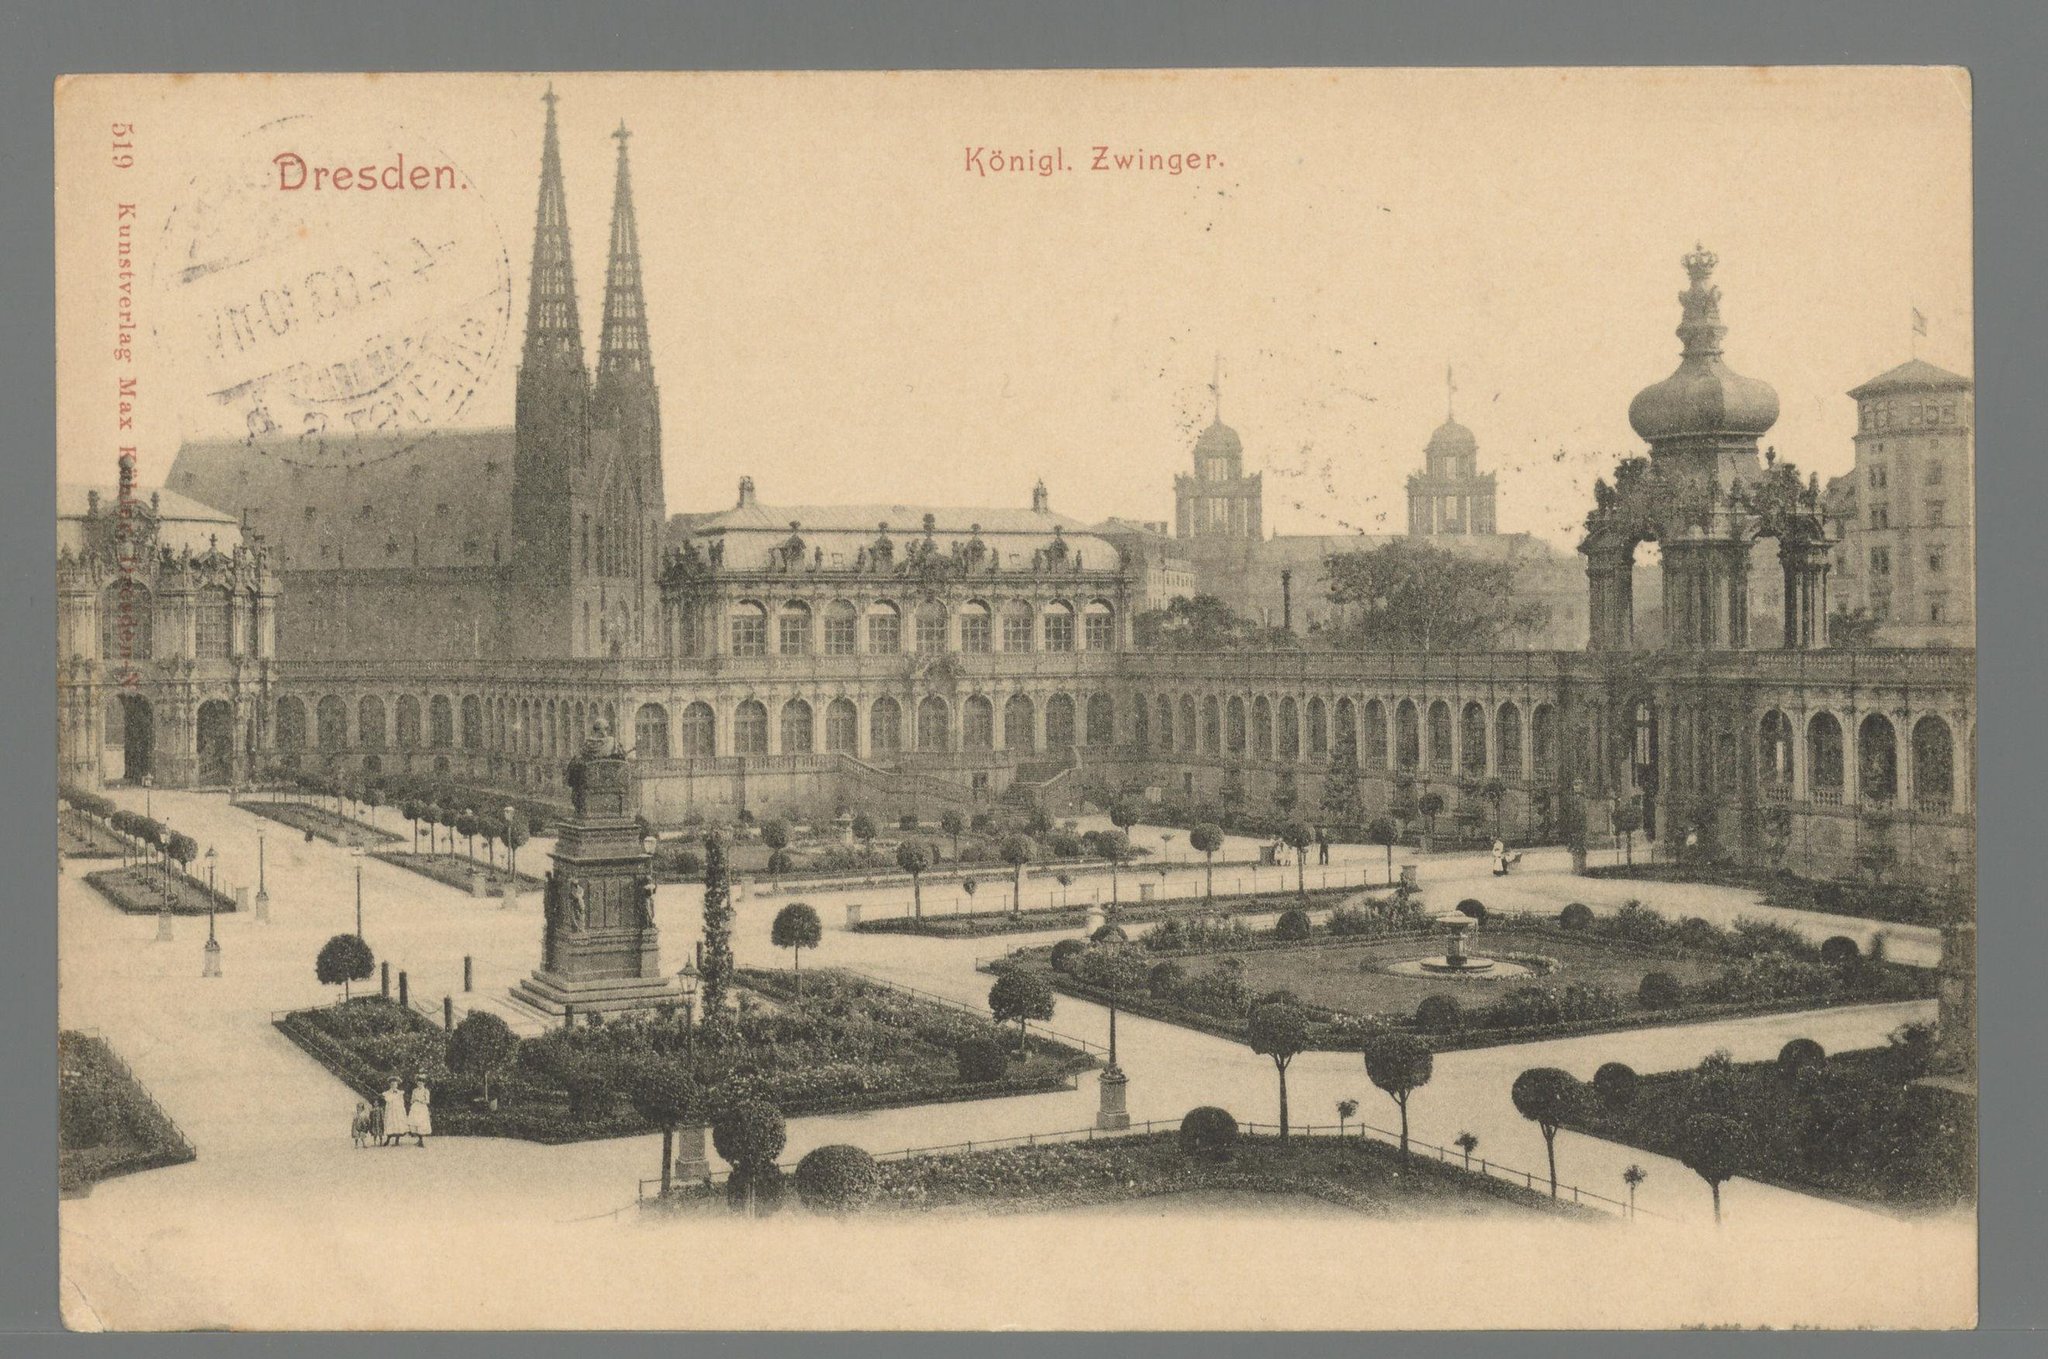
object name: ansichtkaart, prentbriefkaart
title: Dresden. Königl. Zwinger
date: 1885-1903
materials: cardboard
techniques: photograph, writing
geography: dresden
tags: garden, palace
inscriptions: postage stamp